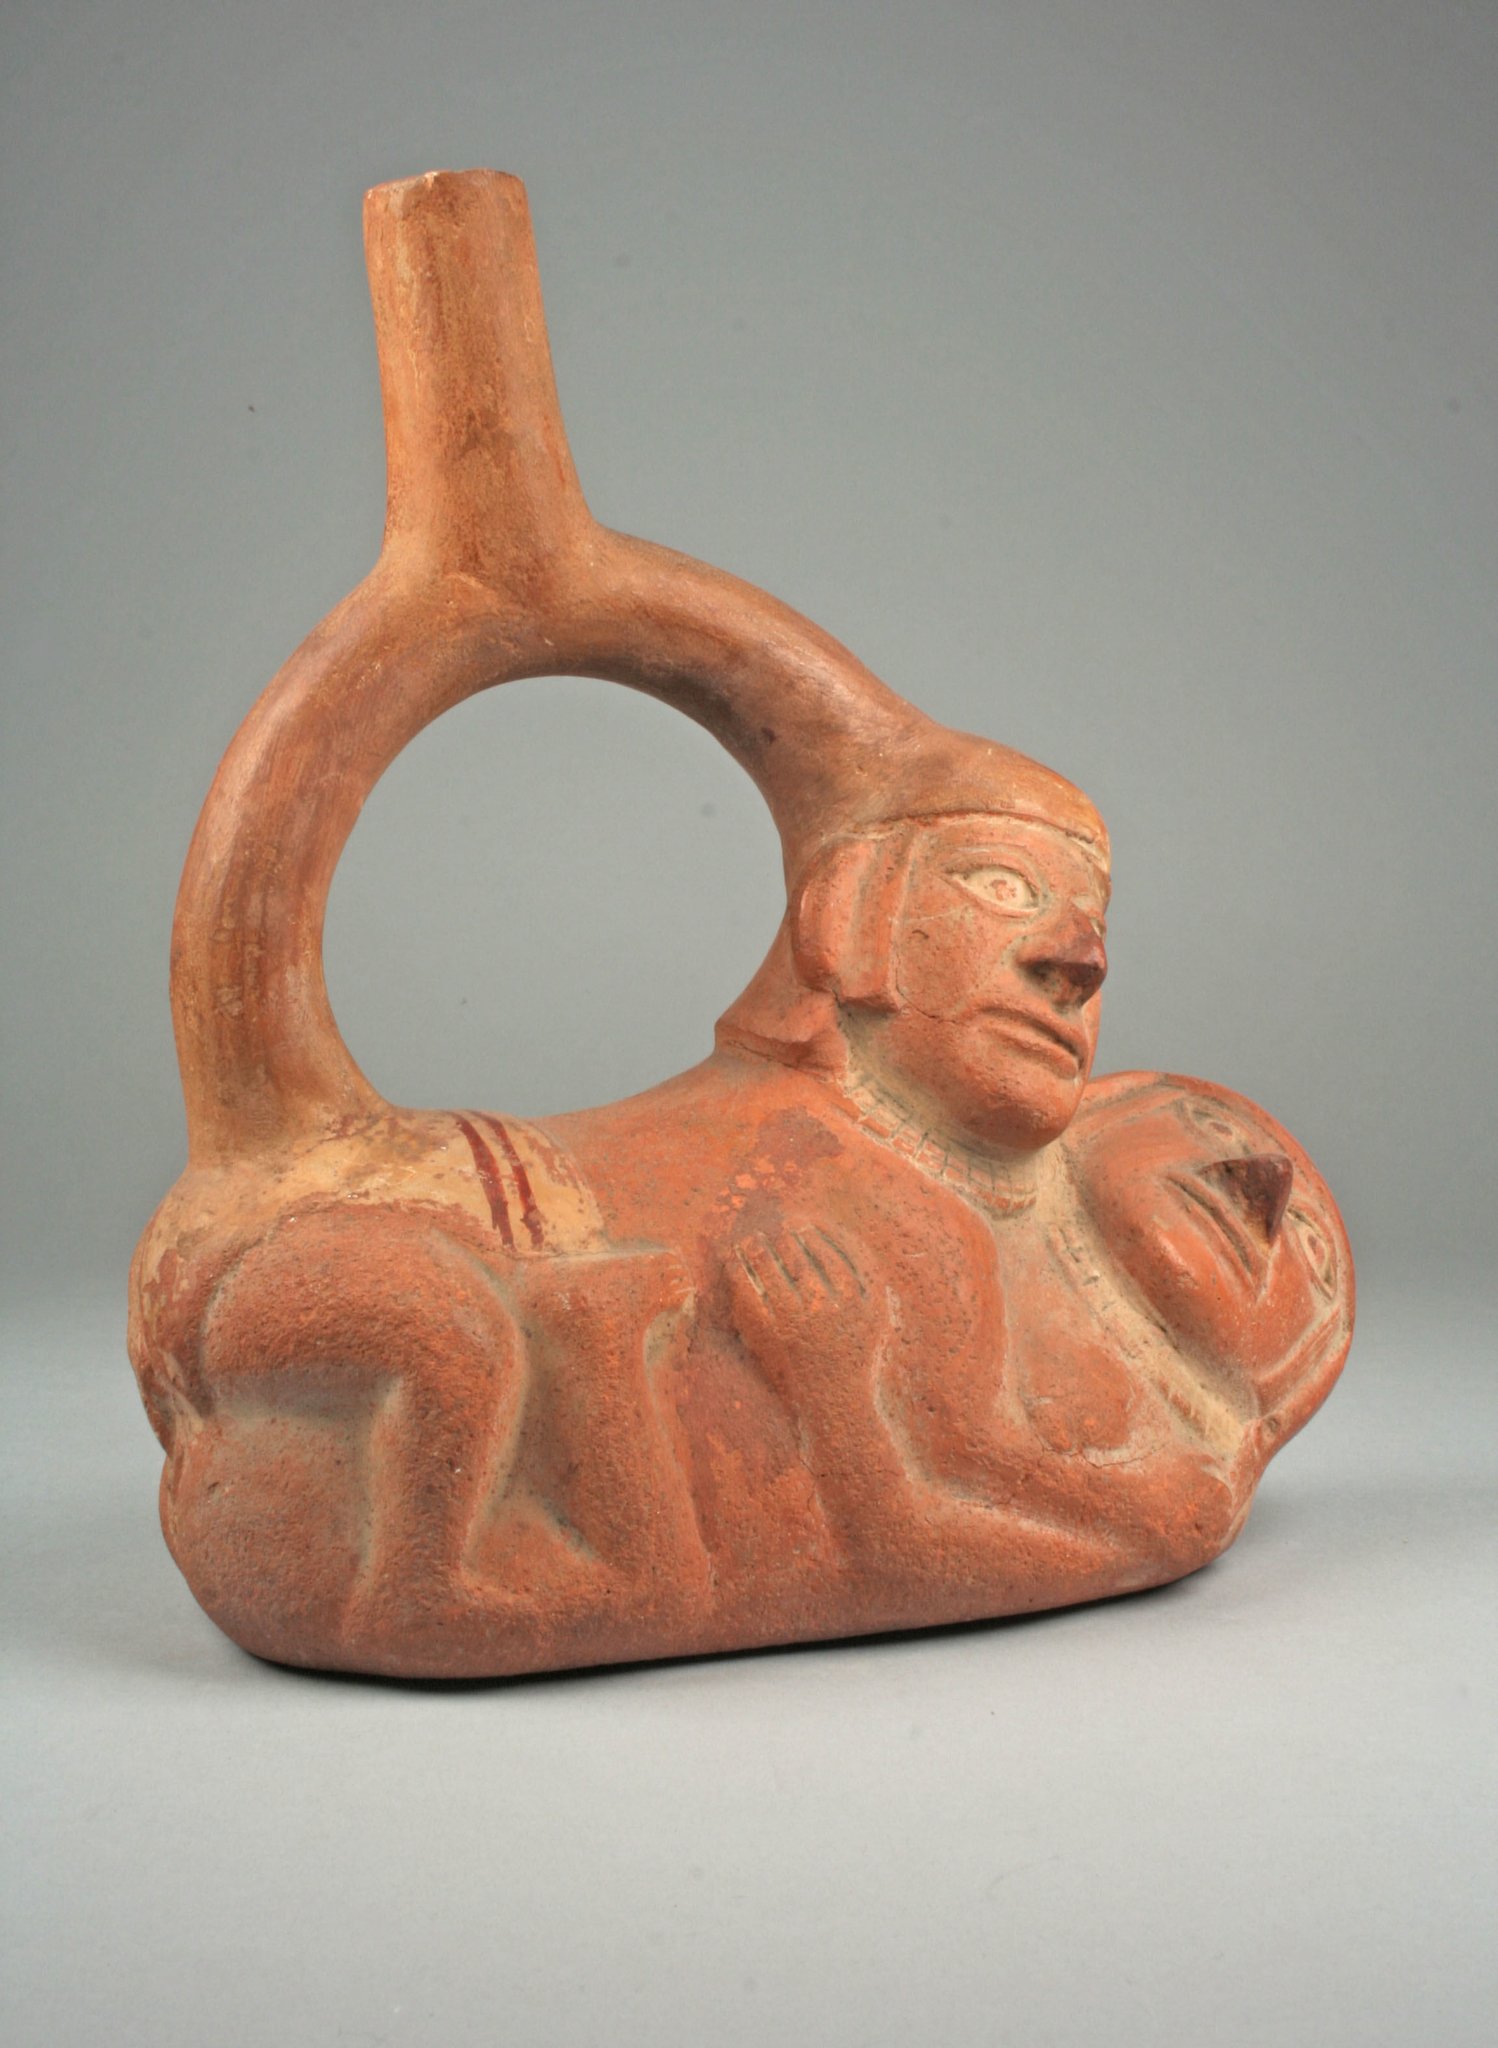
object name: bottle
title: Stirrup Spout Bottle with Couple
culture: moche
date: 201-600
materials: ceramic, pigment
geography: peru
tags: couples